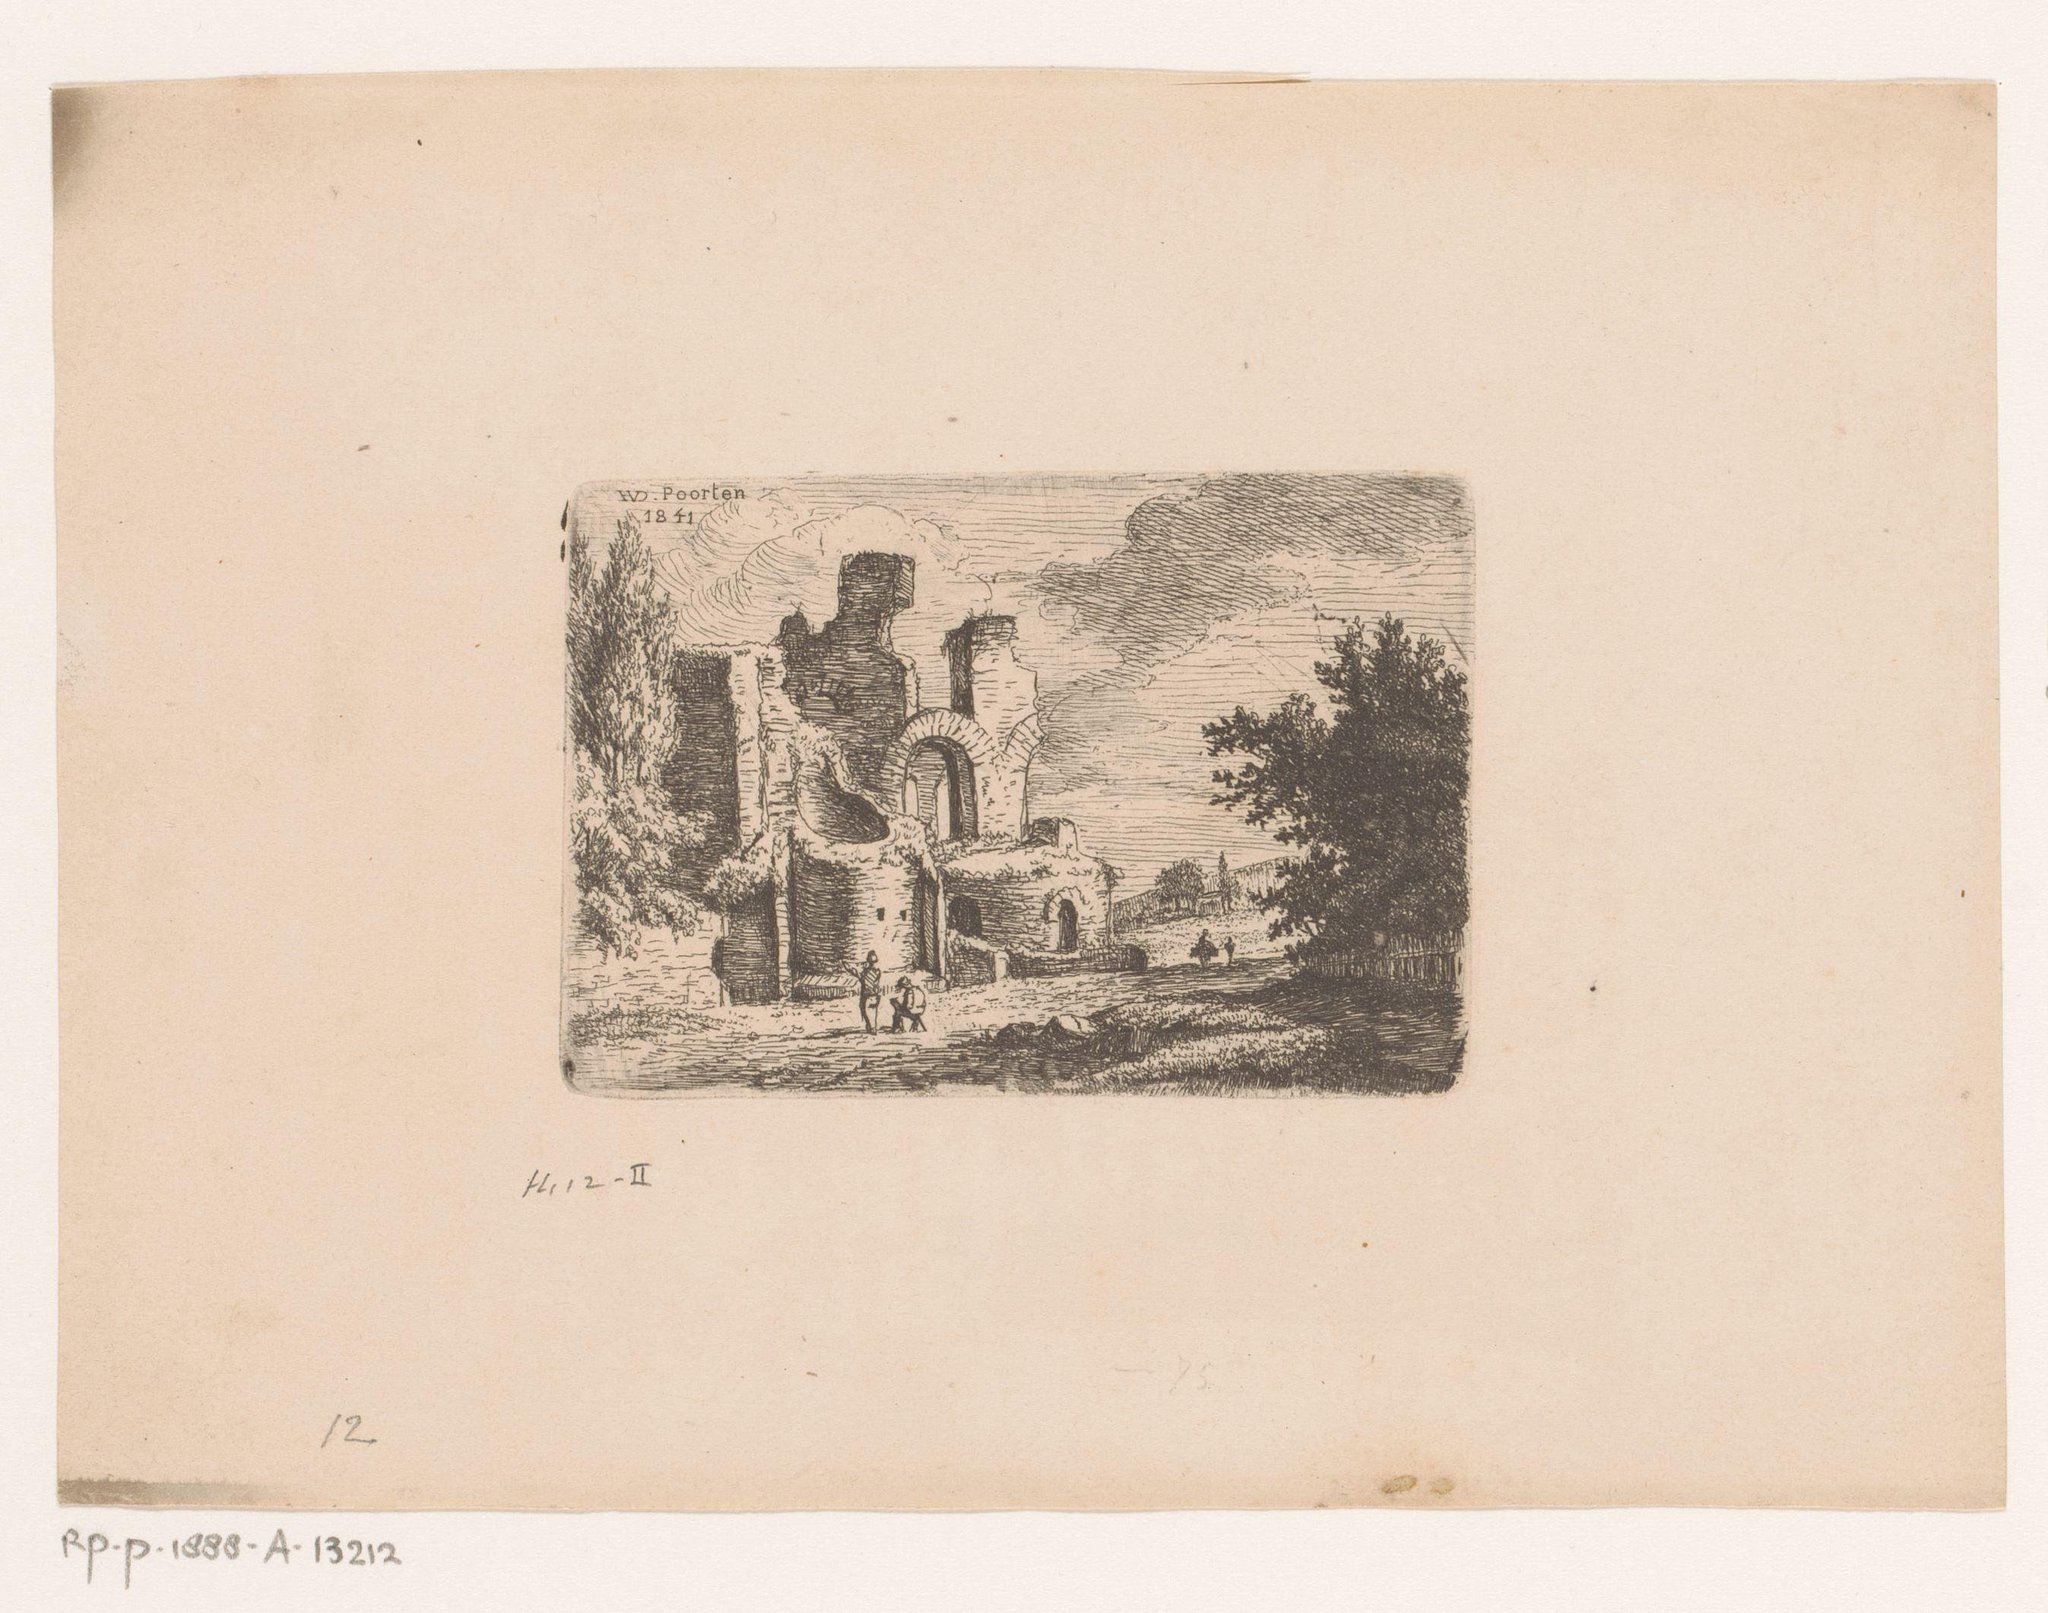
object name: print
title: Ruïne van de Keizerthermen in Trier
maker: hendrik jozef franciscus van der poorten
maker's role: draughtsman, print maker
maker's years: 1789-1874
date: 1841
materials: paper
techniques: etching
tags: ruin of a building ~ architecture, landscape with ruins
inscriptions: collector's mark: Lugt 2228